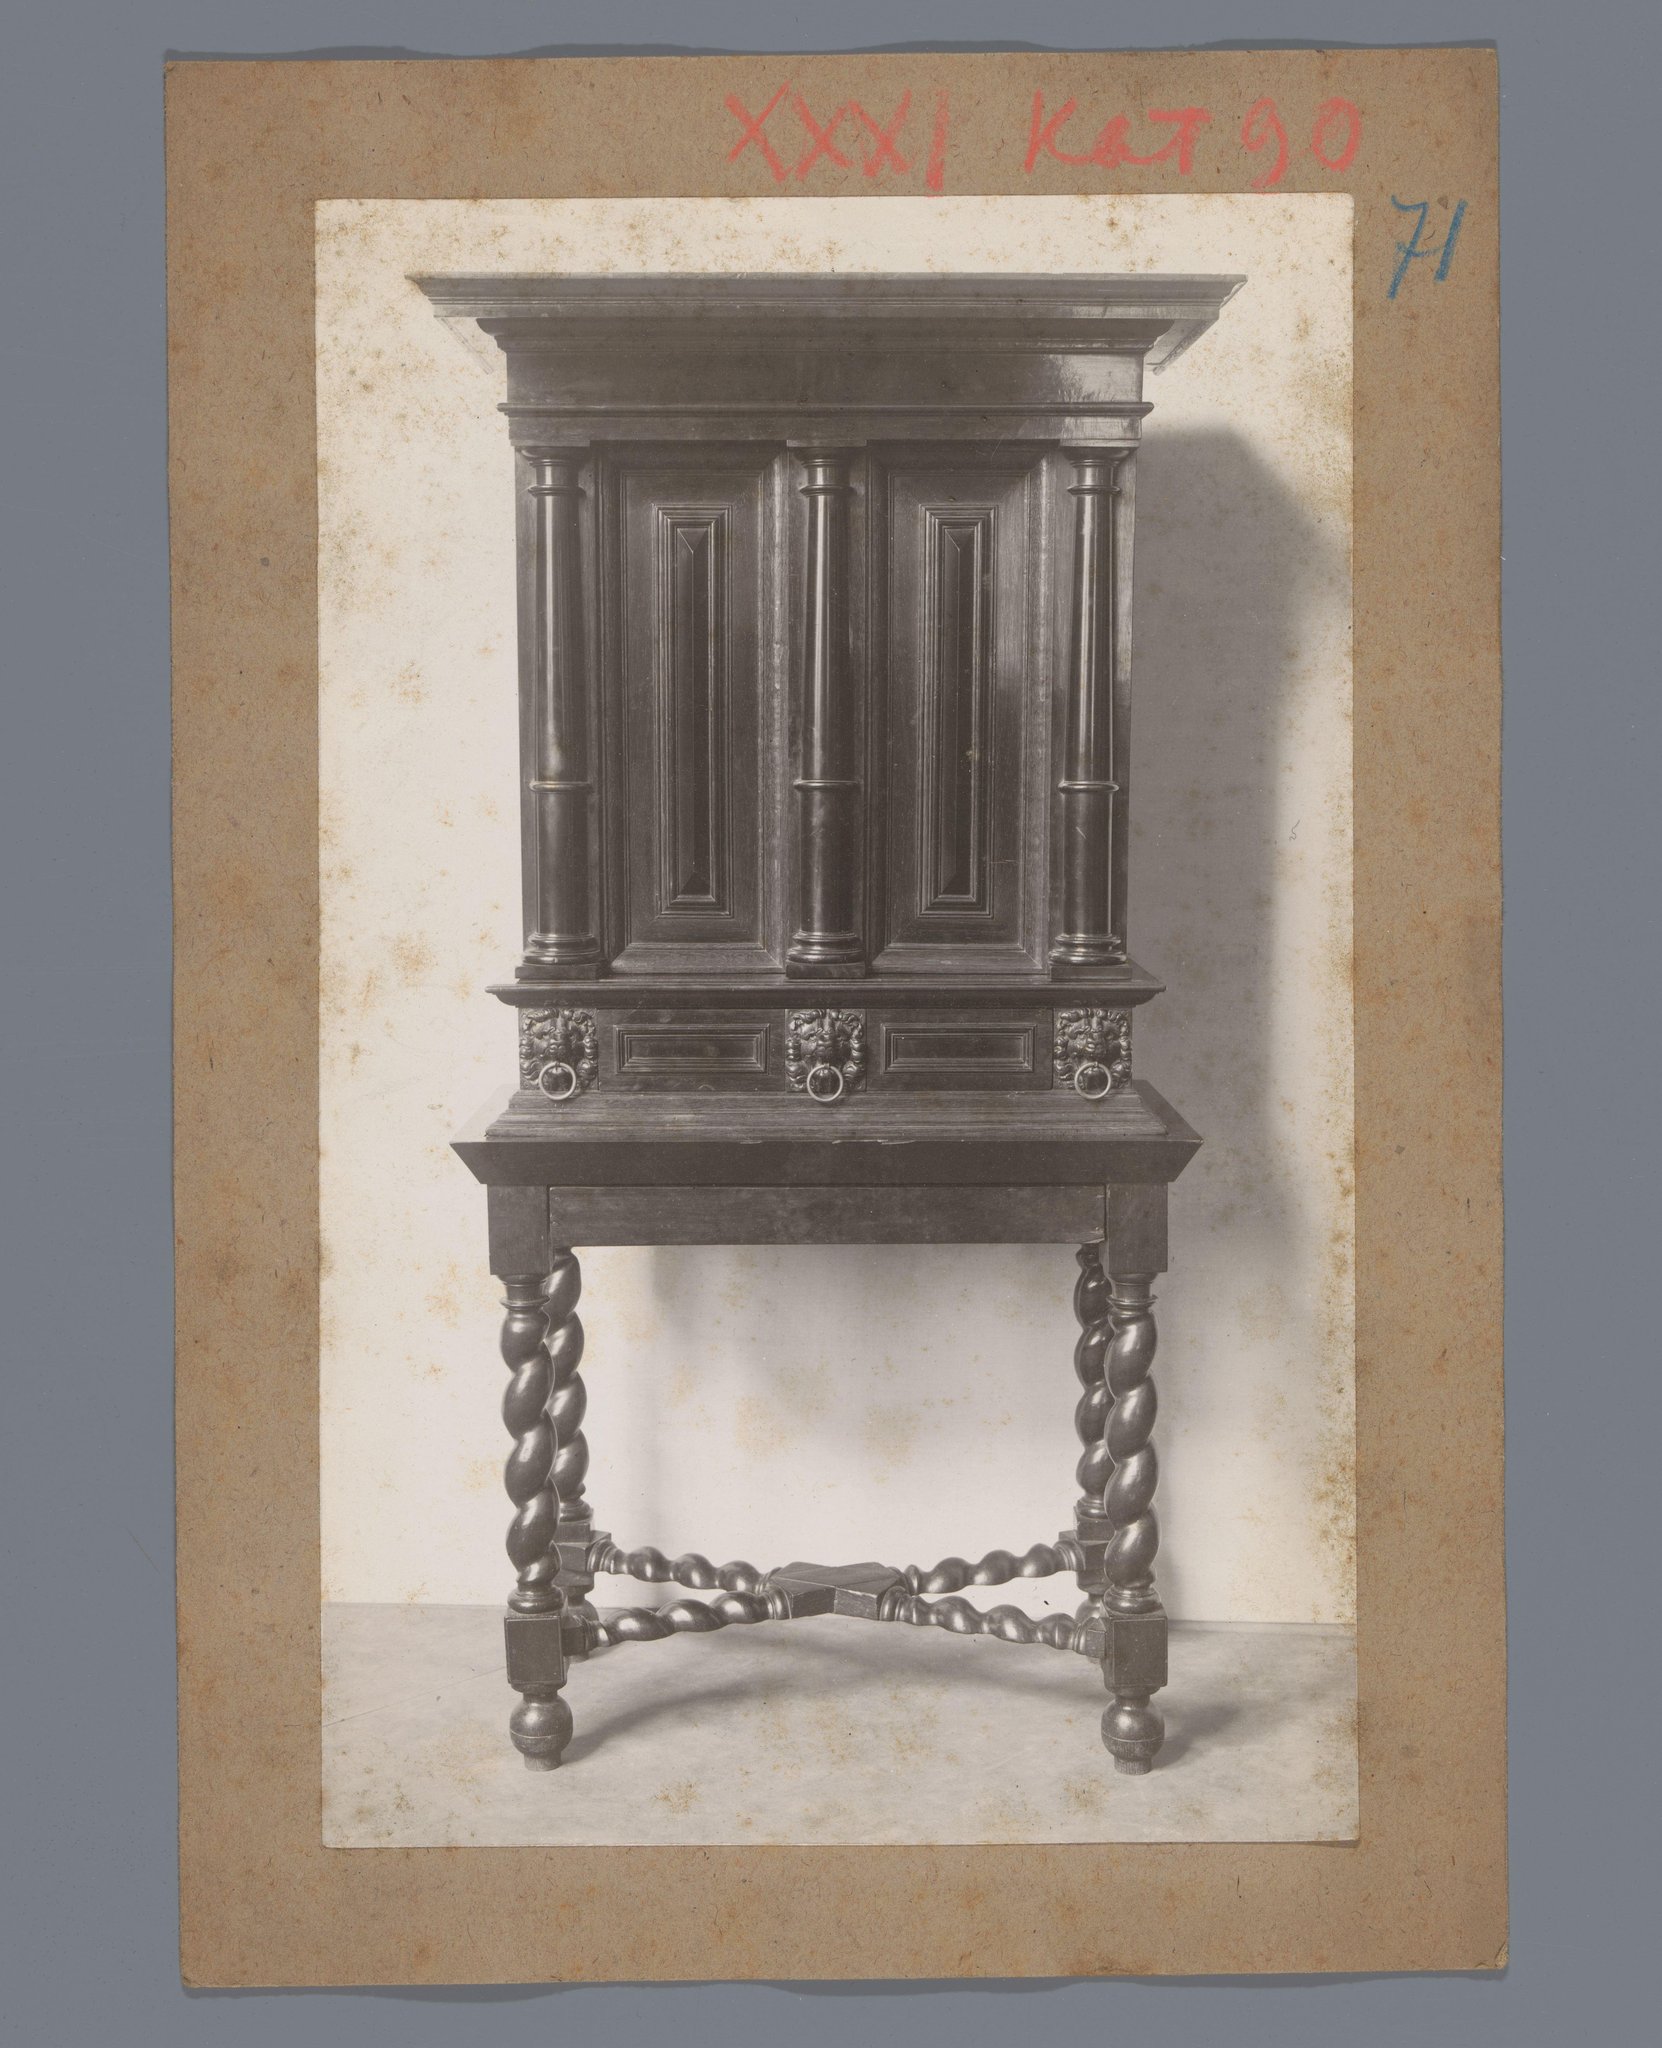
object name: photograph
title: Kast gedecoreerd met leeuwenkoppen (vermoedelijk) in het Rijksmuseum te Amsterdam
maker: Anonymous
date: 1875-1900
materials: photographic support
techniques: matte daylight collodion silver print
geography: amsterdam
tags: cupboard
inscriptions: collector's mark: ‘Kunstnijverheidschool Quellinus Amsterdam Frans Halsstraat 14.’, collector's mark: ‘Instituut voor kunst-nijverheidsonderwijs Gabriël Metsustraat No. 16, Amsterdam’, number: ‘XXXI Kat 90 71’